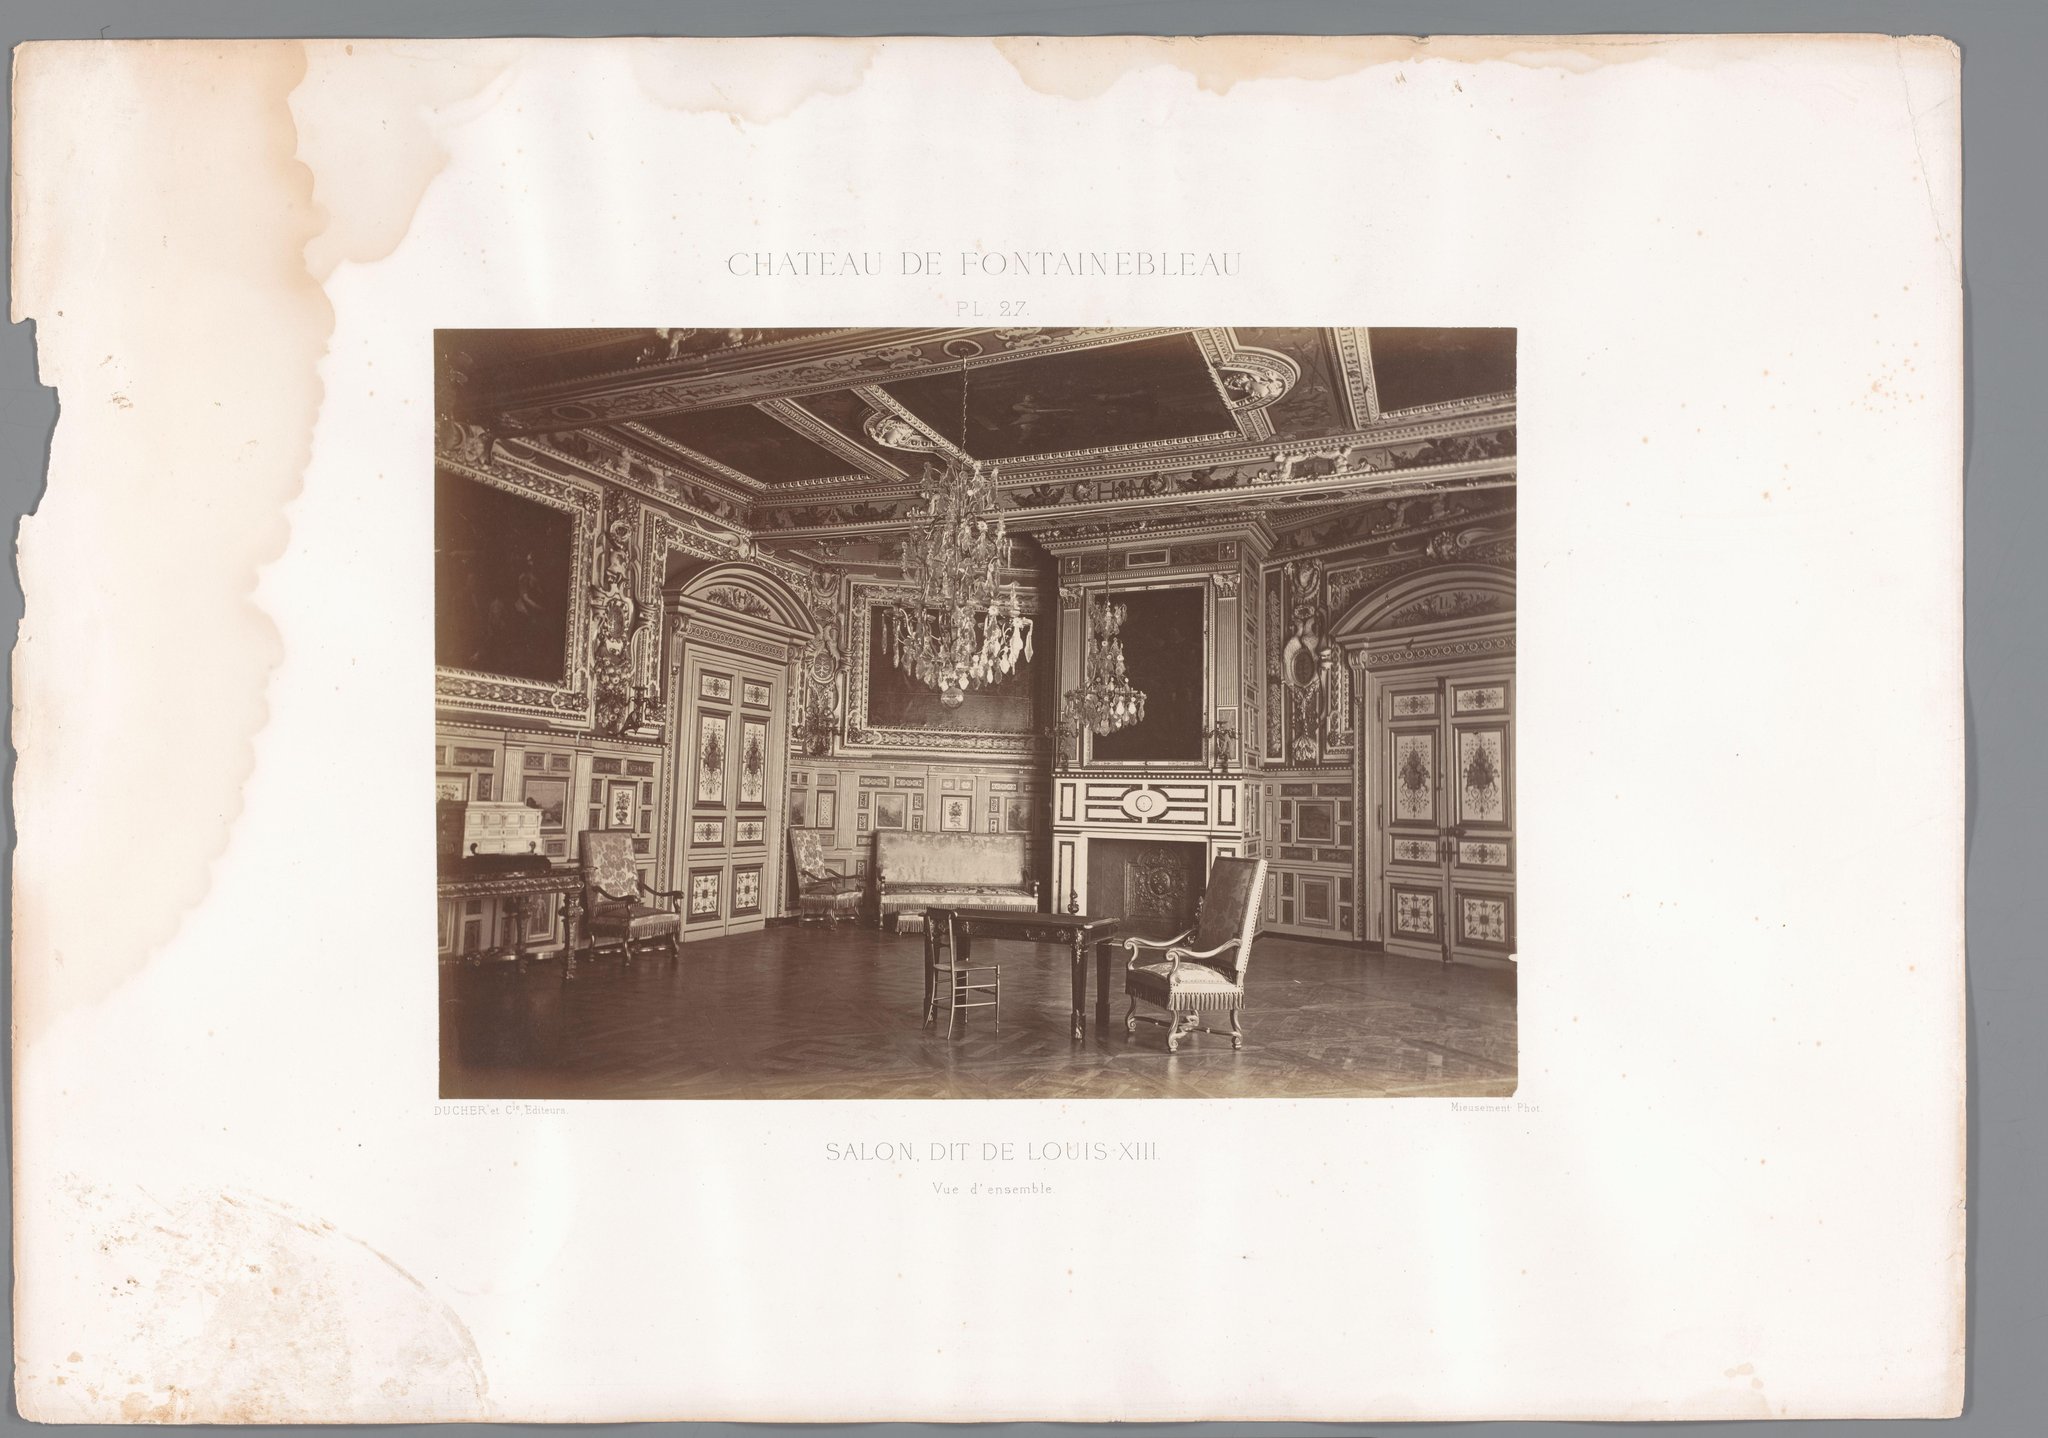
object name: photograph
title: Salon, Dit de Louis XIII - Vue d'Ensemble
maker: séraphin-médéric mieusement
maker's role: fotograaf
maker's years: 1840-1905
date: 1870-1875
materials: photographic support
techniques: albumen print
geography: fontainebleau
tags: castle - aa - civic architecture: inside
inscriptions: number: ‘PL. 27.’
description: Deze foto maakt deel uit van een omslag met dertig foto's en twee tekstbladen.